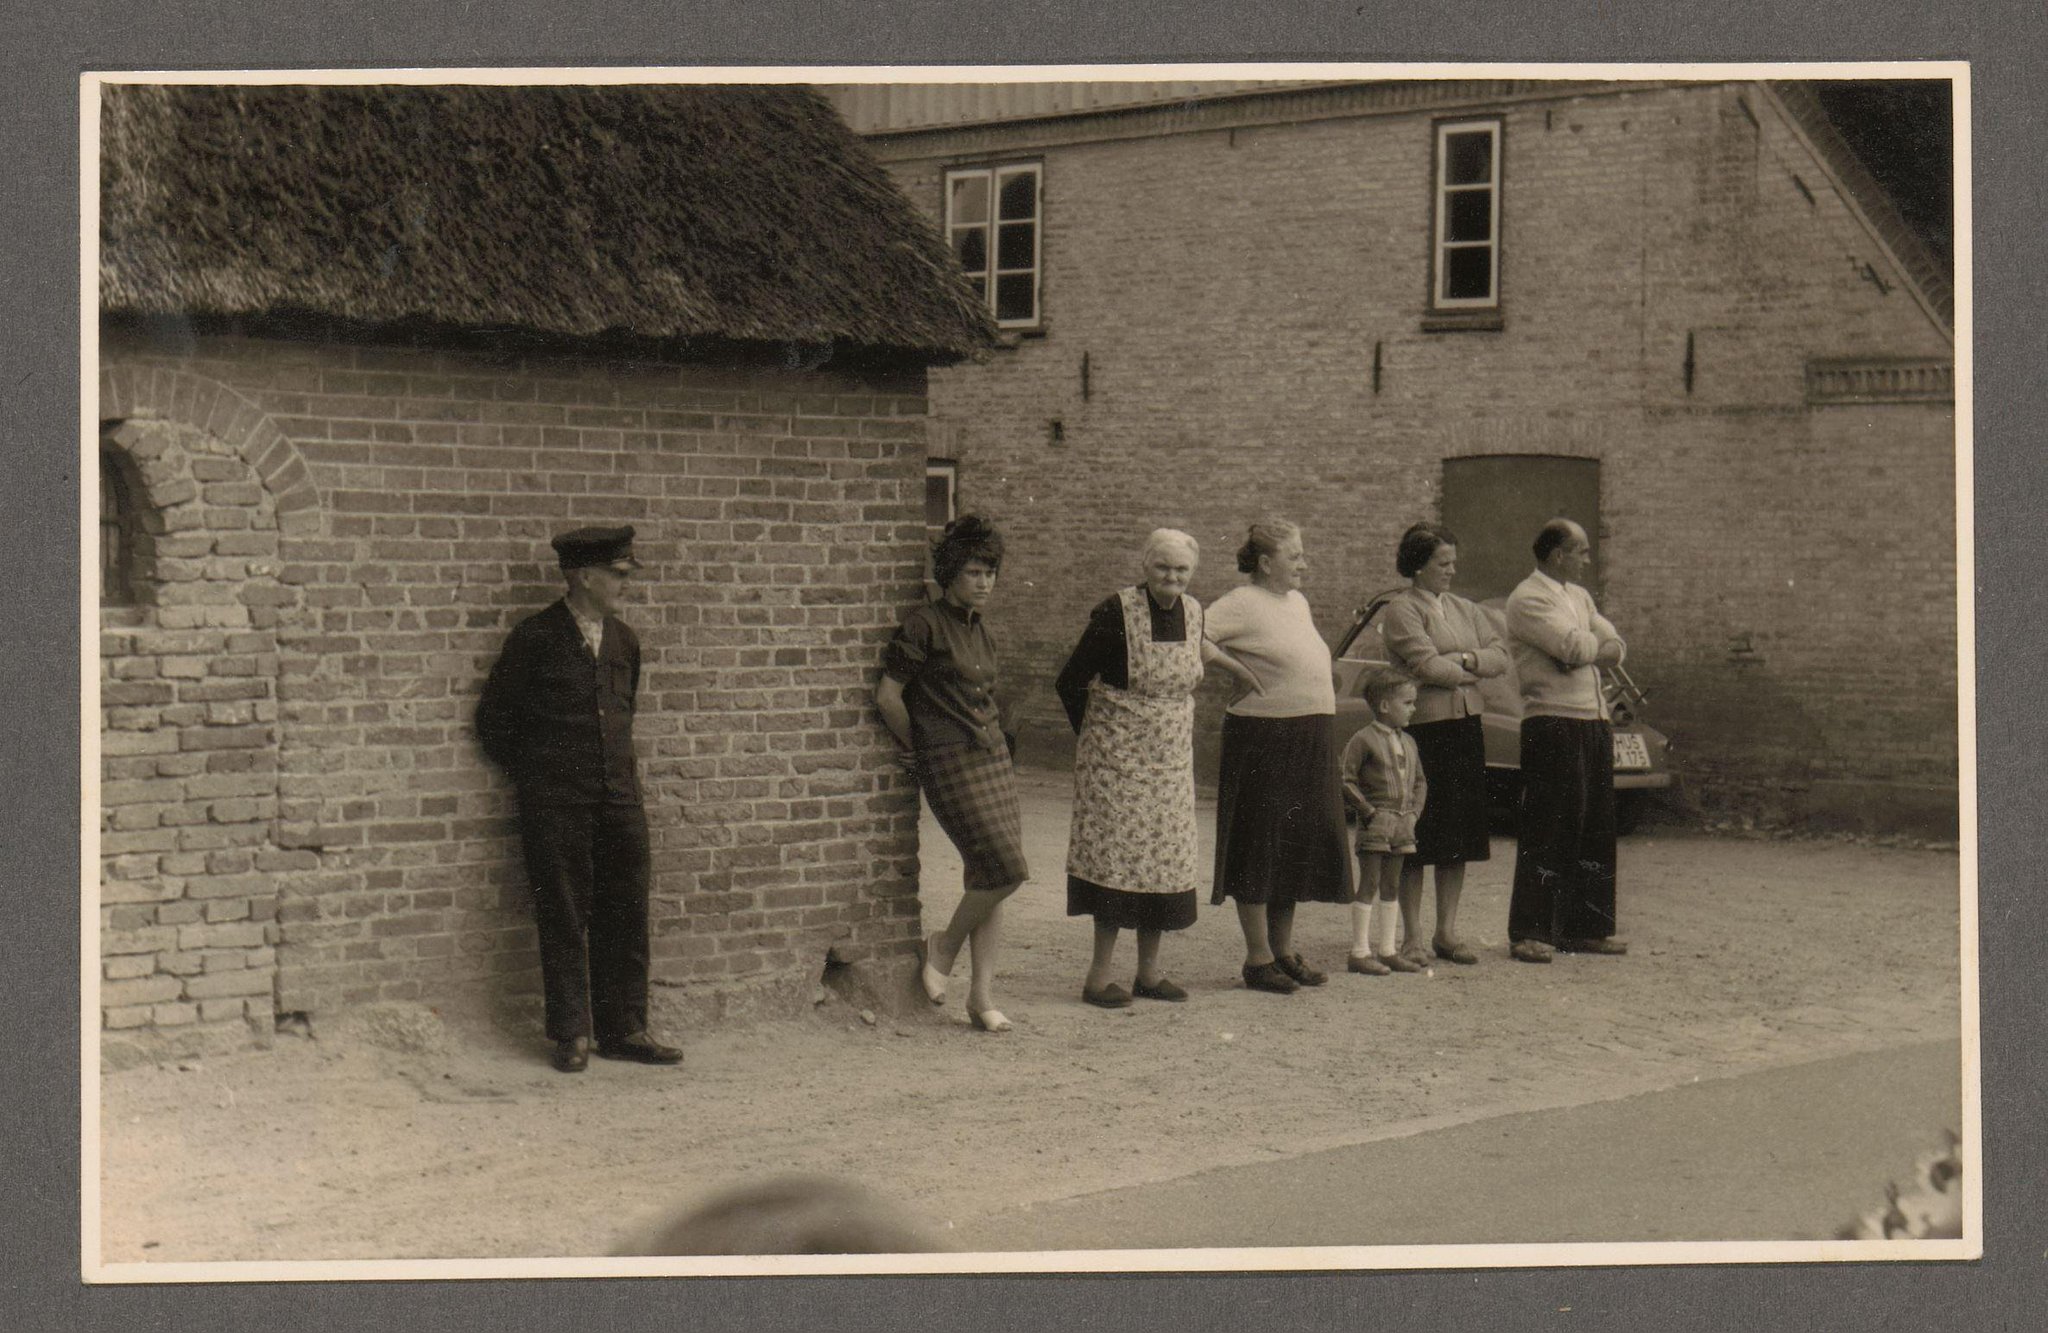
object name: album leaf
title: Familie langs een weg voor een woning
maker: Anonymous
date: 1930-1950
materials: paper, photographic support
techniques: gelatin silver print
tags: historical persons, family, relationship, descent, civic architecture; edifices; dwellings